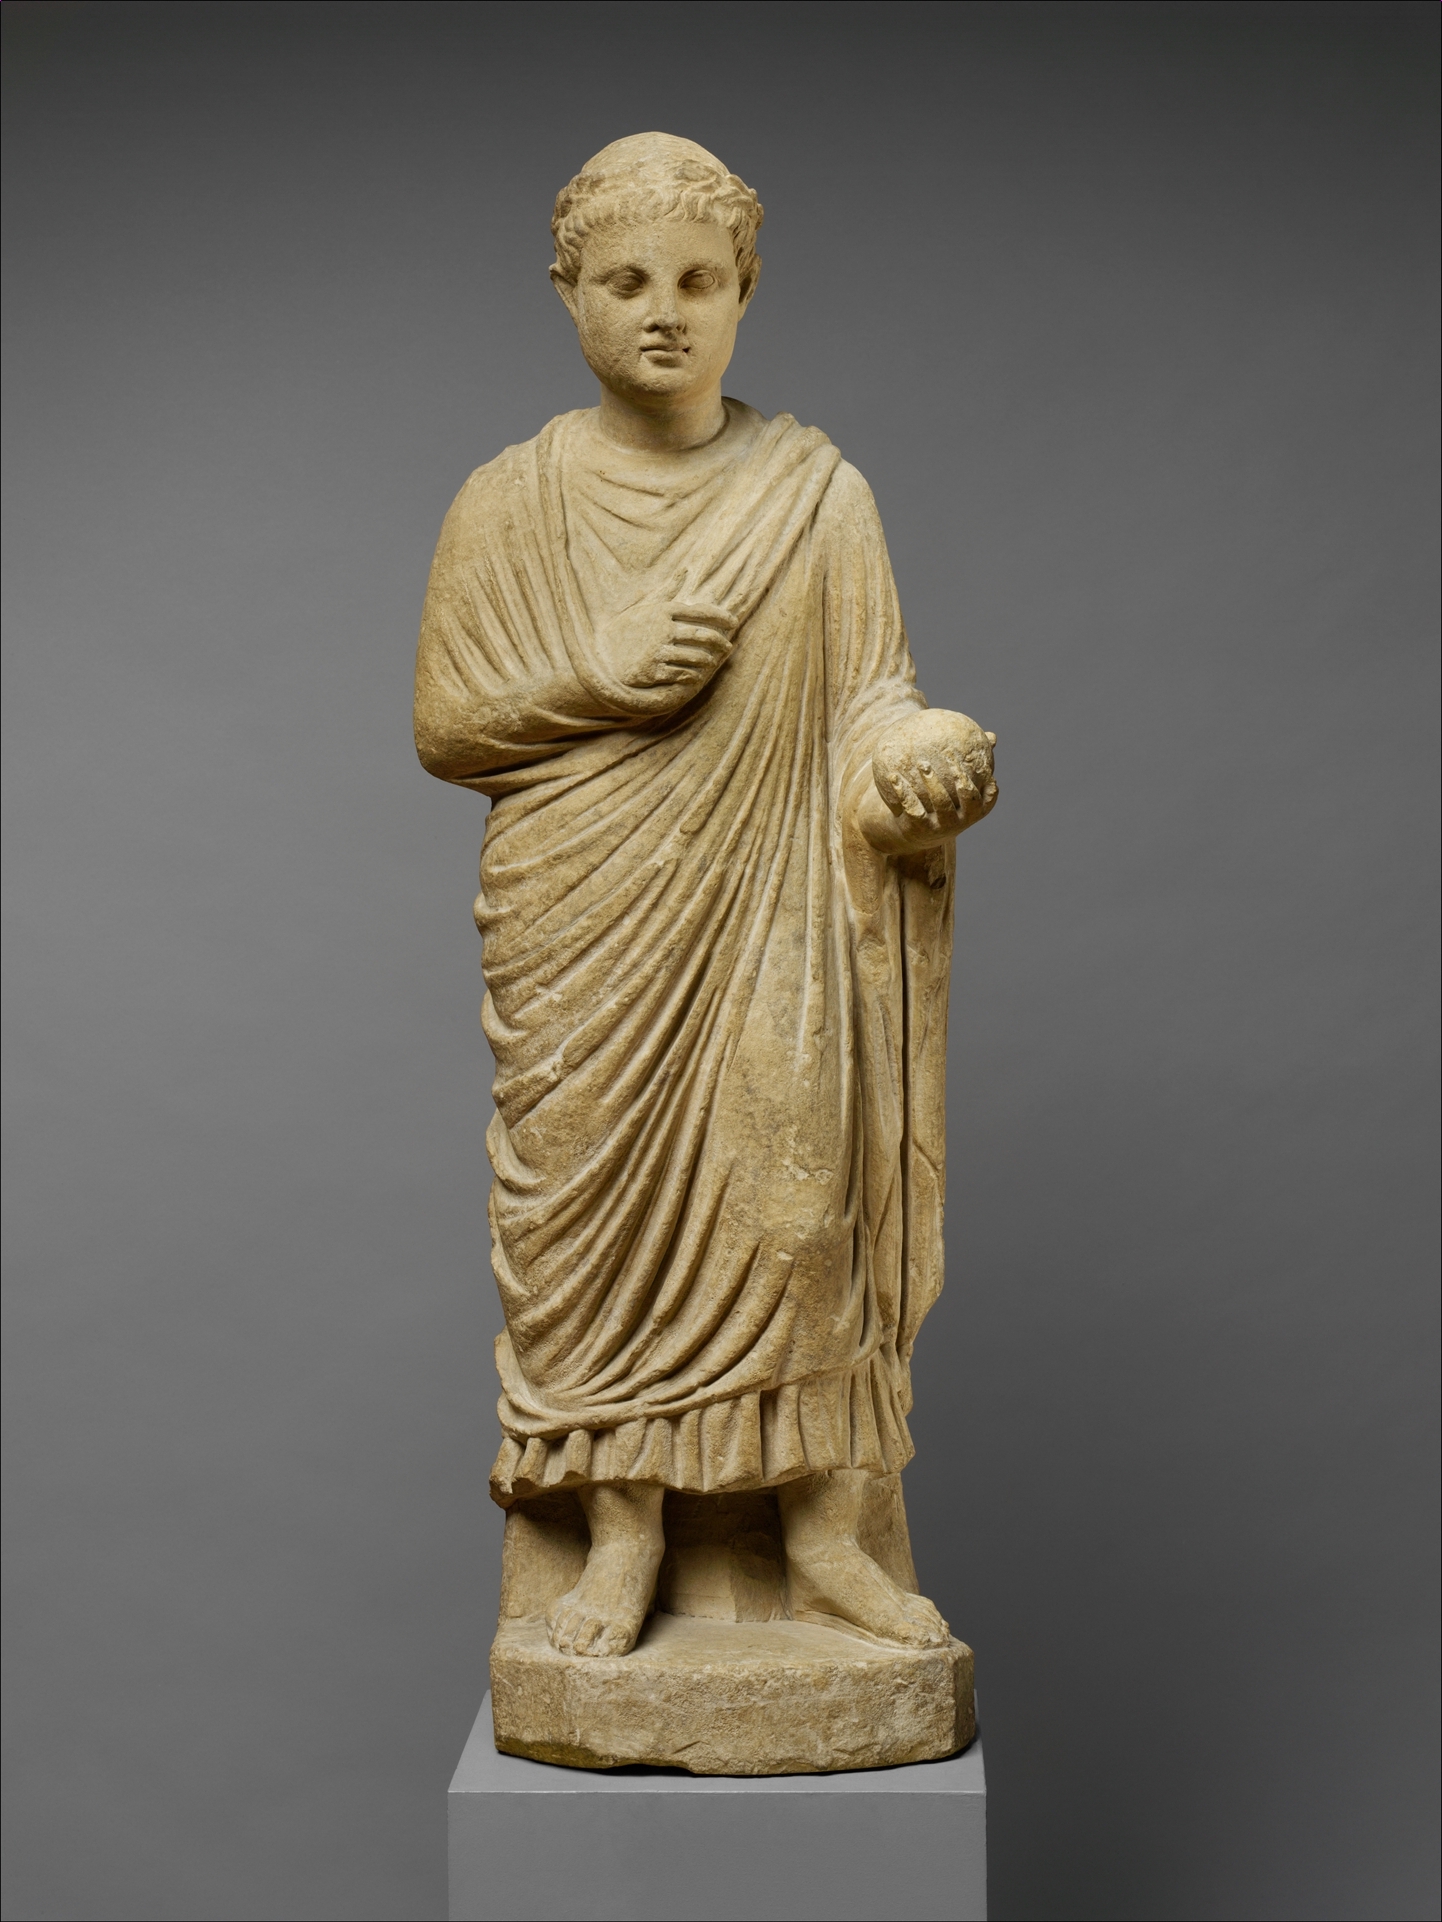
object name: statue of a votary holding an apple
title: Limestone statue of a wreathed boy holding a ball or piece of fruit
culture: cypriot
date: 300 BCE-100 CE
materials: limestone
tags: fruit,men